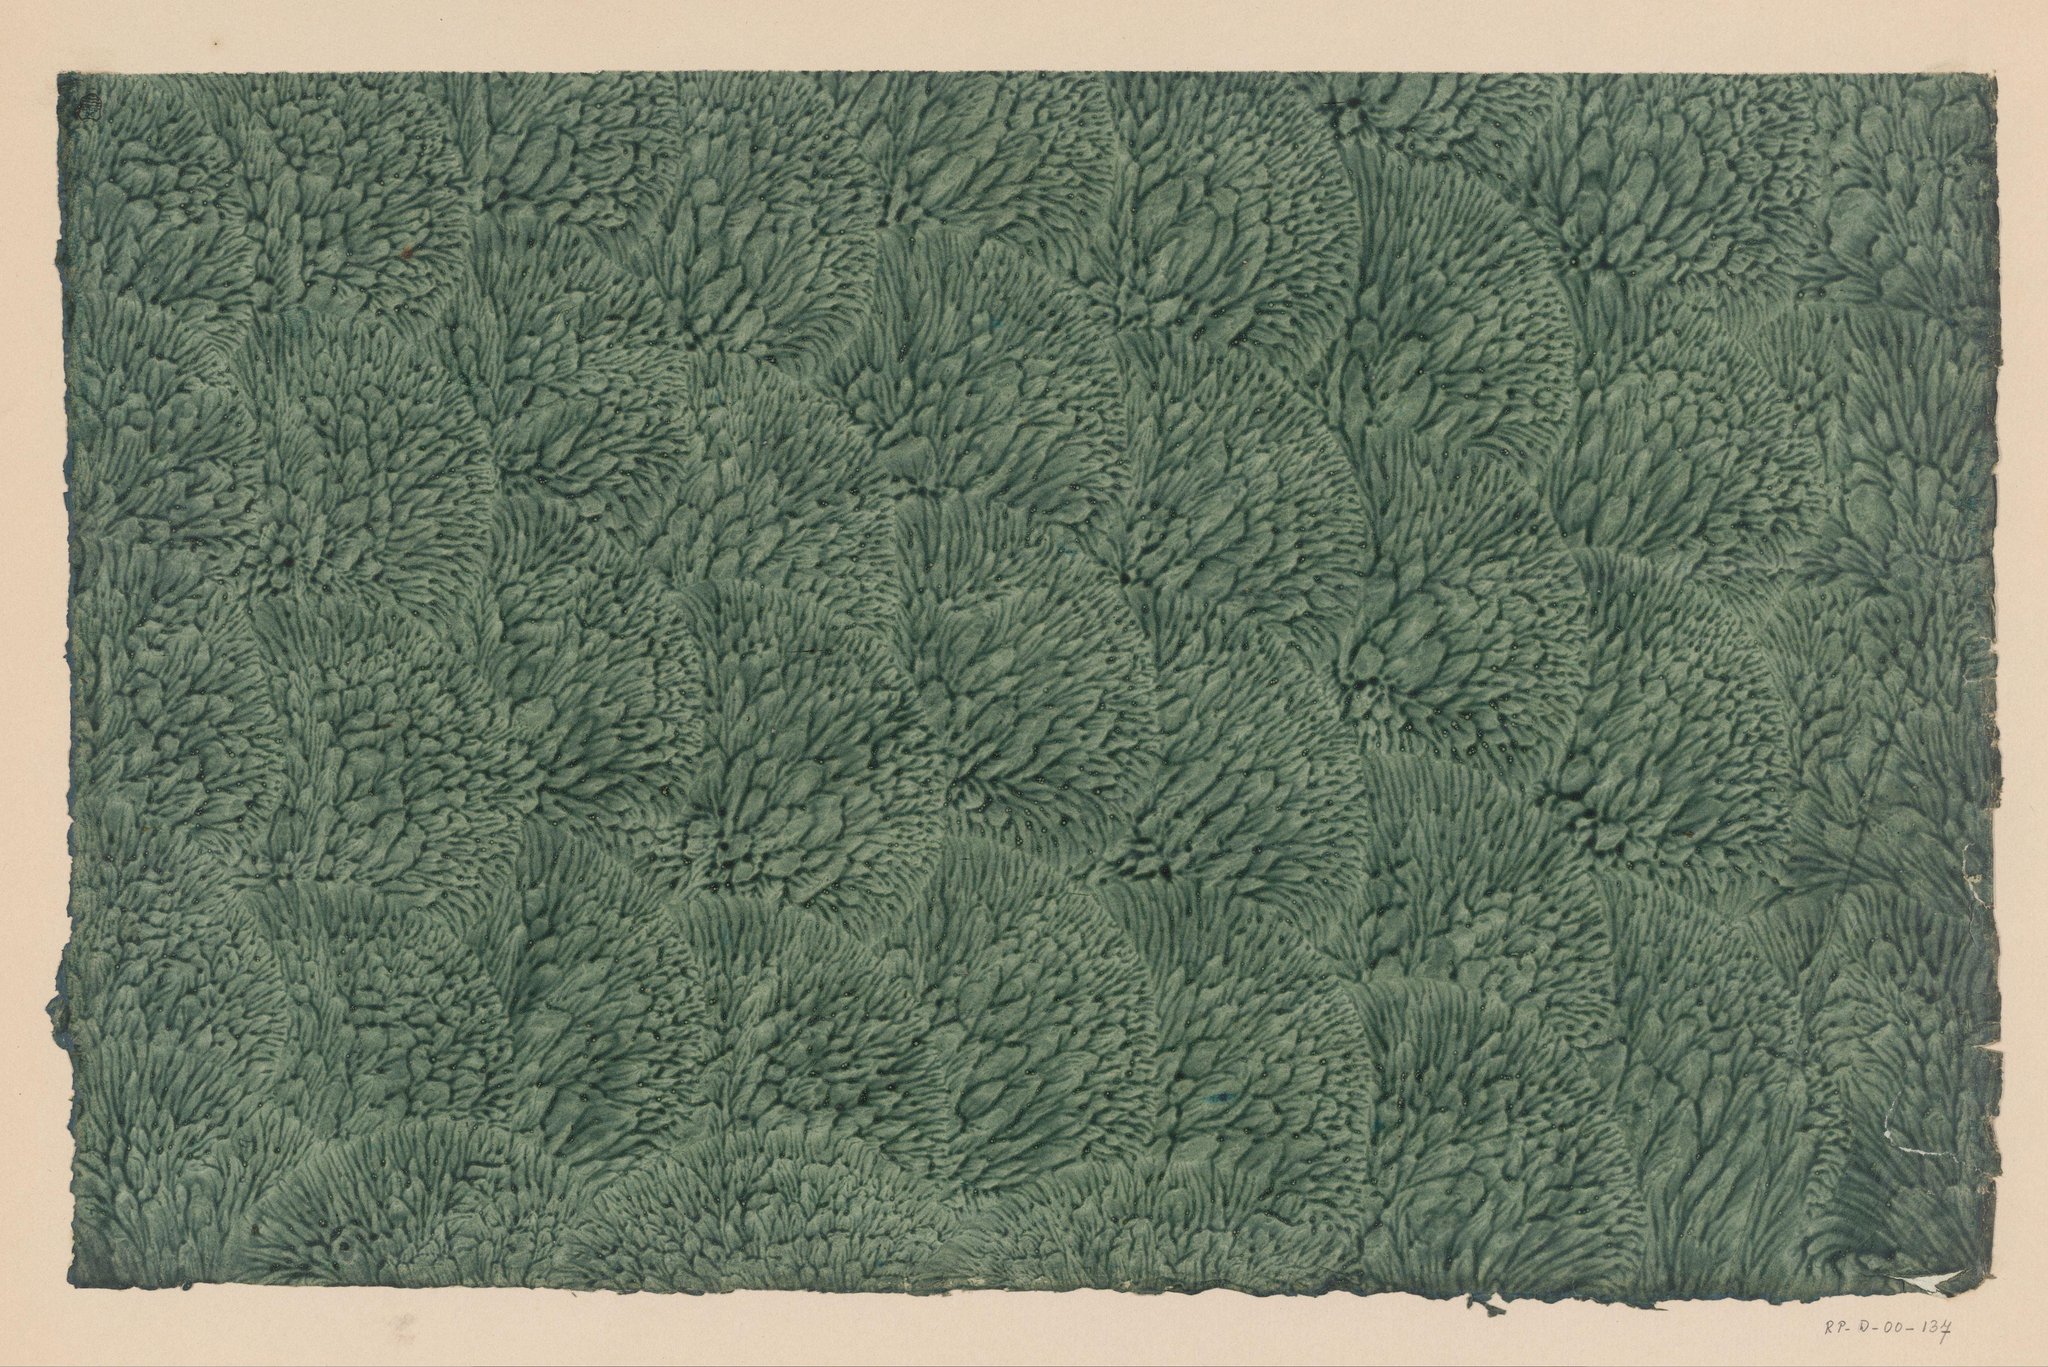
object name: paste paper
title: Stijfselverfpapier in groen met ingedrukt bloemmotief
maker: Anonymous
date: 1700-1900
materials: paper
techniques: starch dyeing, stamping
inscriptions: collector's mark: Lugt 2760